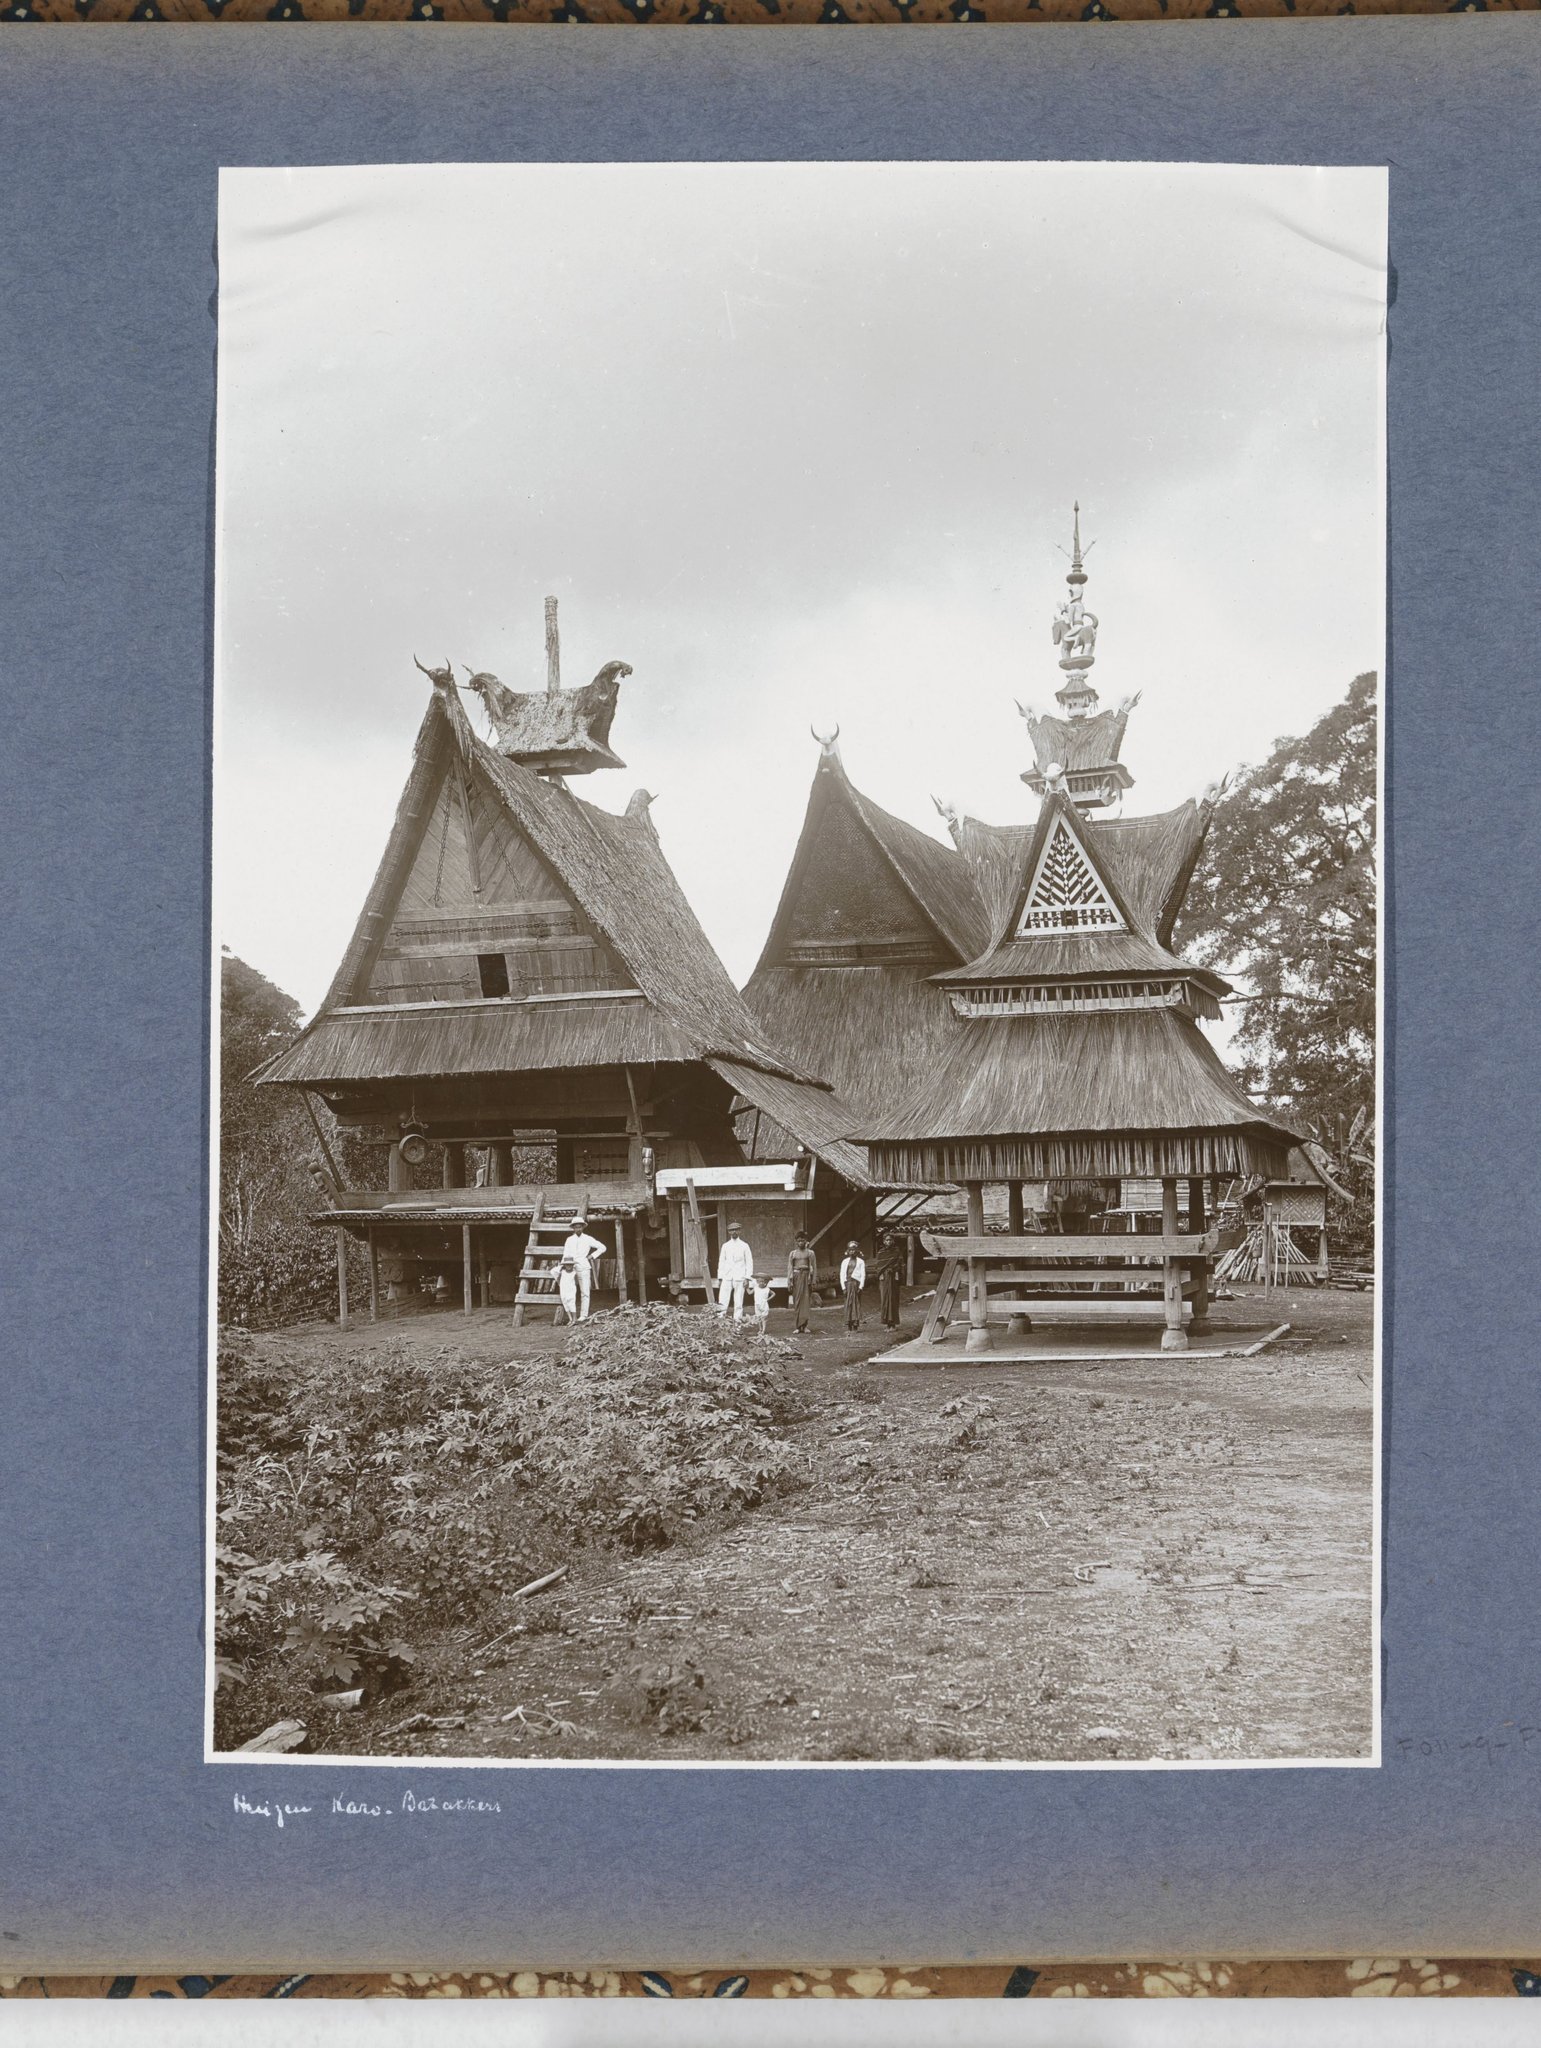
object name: album leaf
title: Exterieur van huizen van Karo Batakkers op Sumatra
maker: christiaan benjamin nieuwenhuis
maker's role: publisher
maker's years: 1863-1922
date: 1900-1920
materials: paper, photographic support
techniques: gelatin silver print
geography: sumatra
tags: exterior ~ representation of a building, sumatra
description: Onderdeel van reisalbum met foto's van bedrijvigheid en bezienswaardigheden op Sumatra en Java en van de reis naar en van Nederlands-Indië.